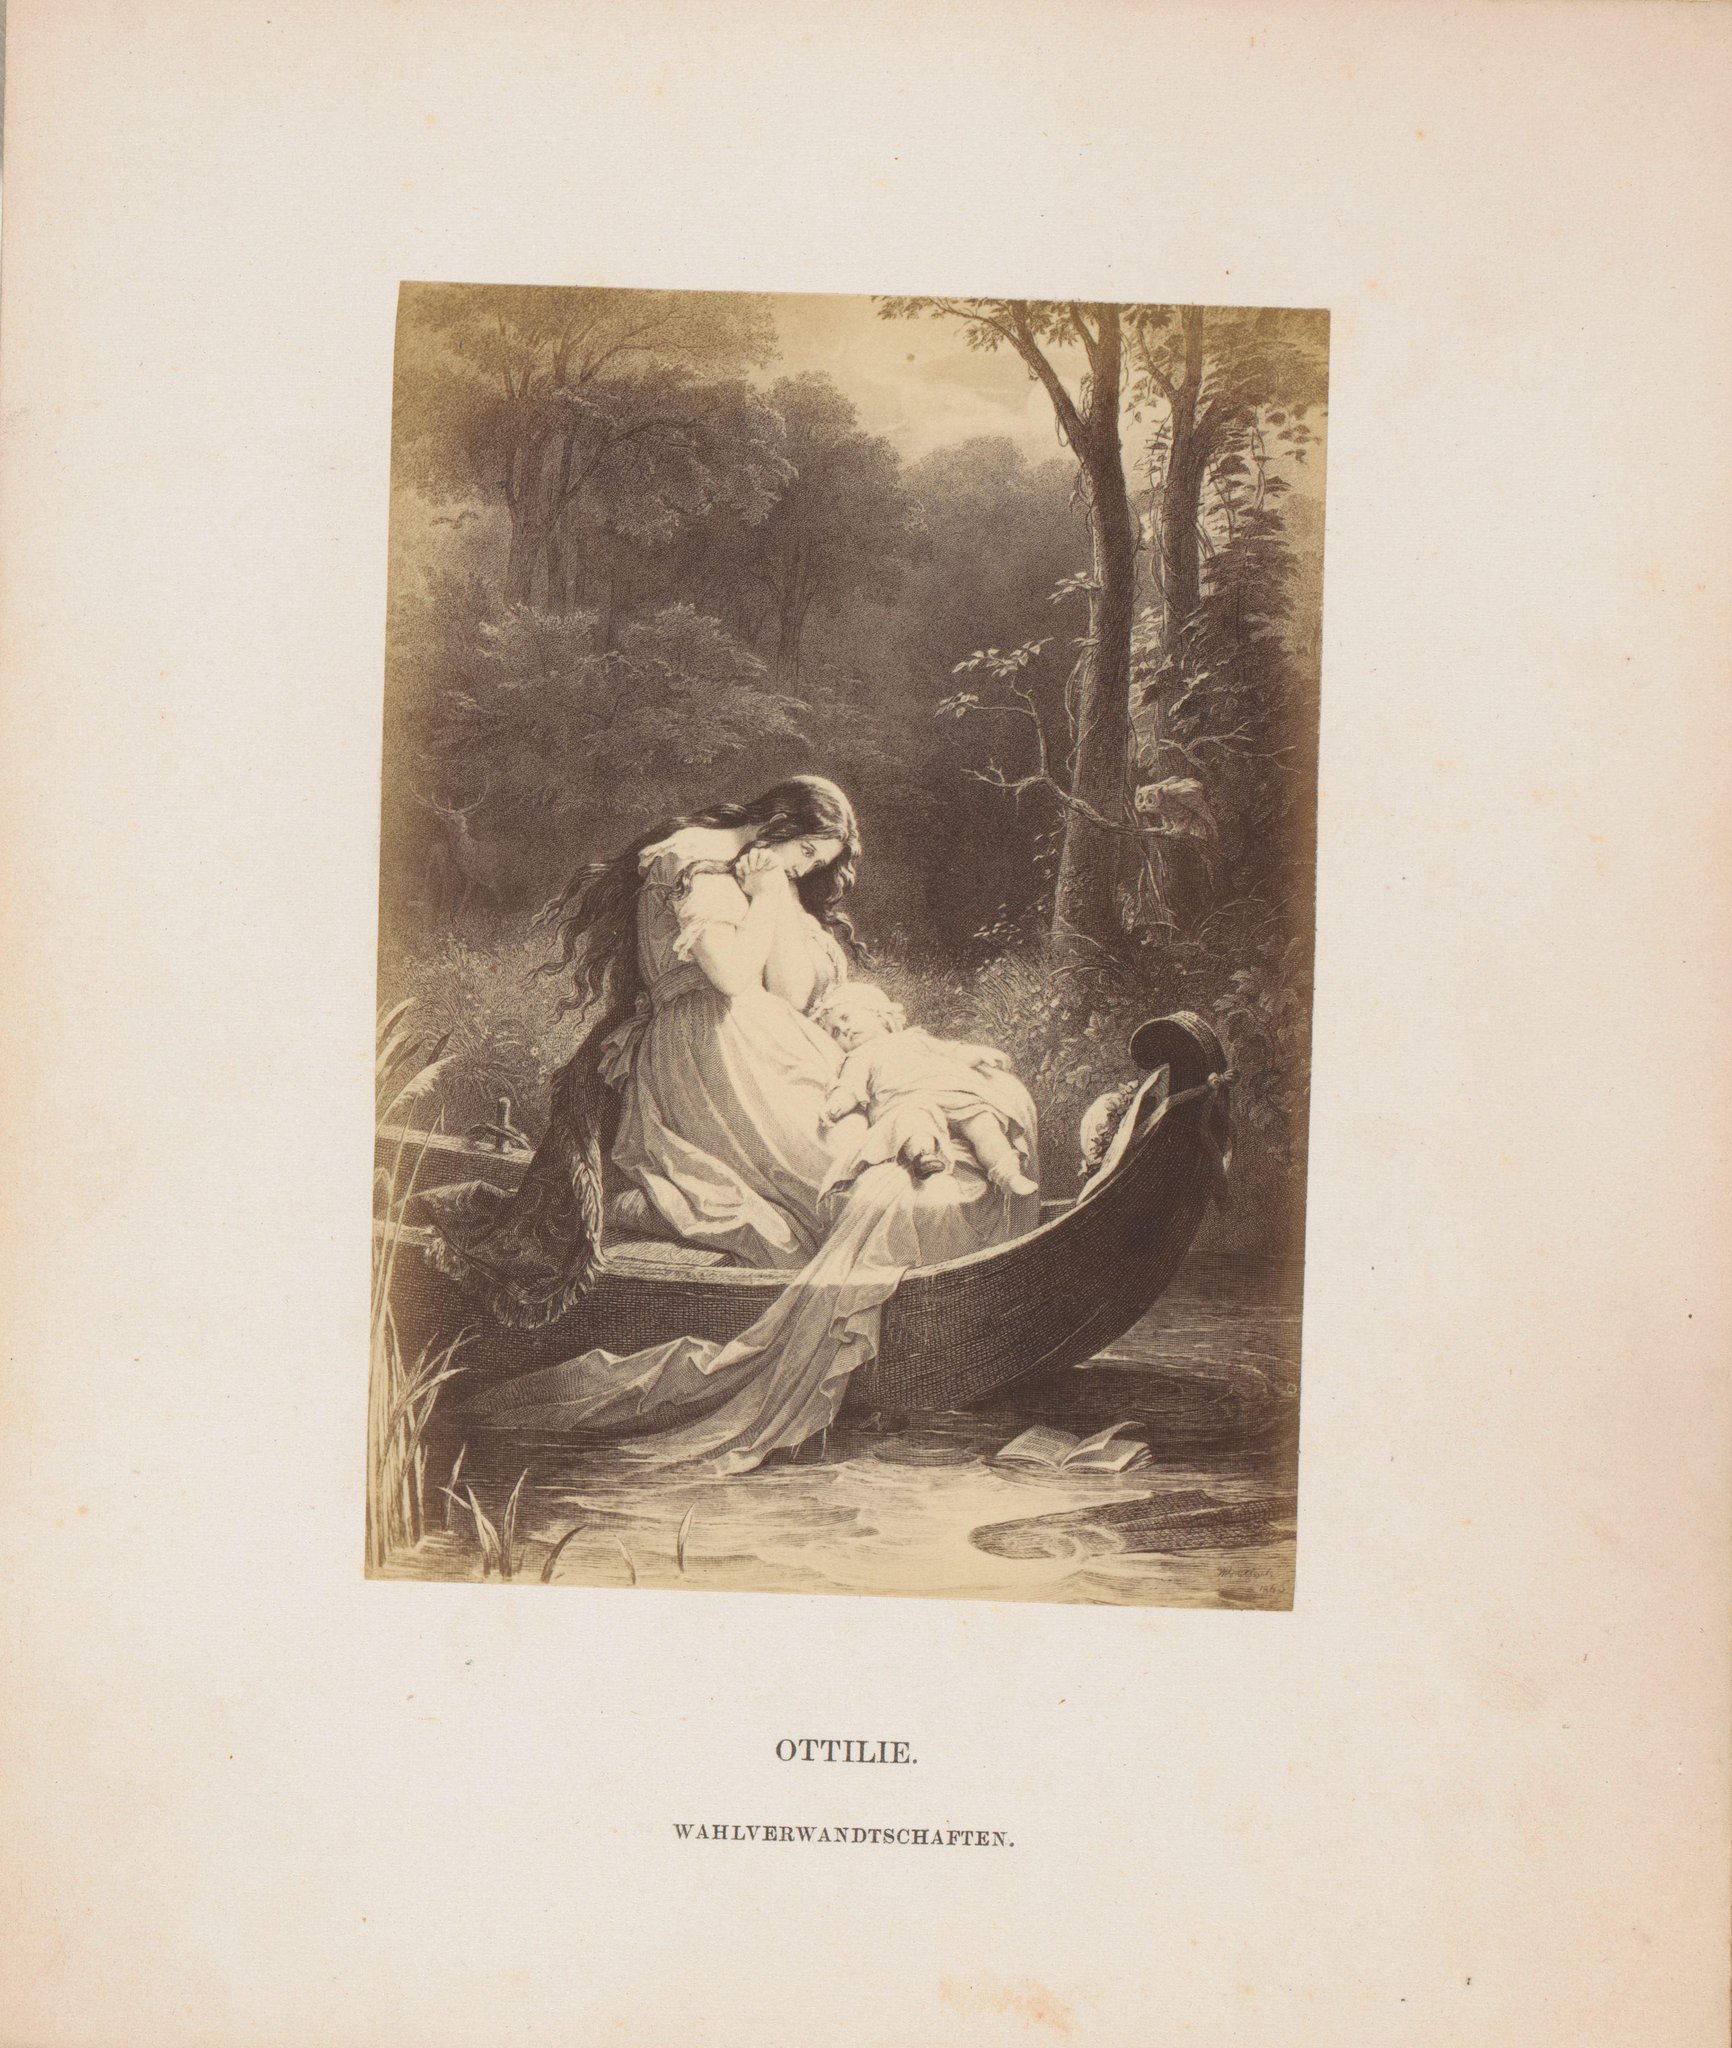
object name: photograph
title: Ottilie. Wahlverwandtschaften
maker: Anonymous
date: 1863-1900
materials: cardboard, photographic support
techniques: albumen print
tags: adult woman, child, rowing-boat, canoe, etc., specific works of literature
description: Deze foto maakt deel uit van een omslag met 22 foto's.